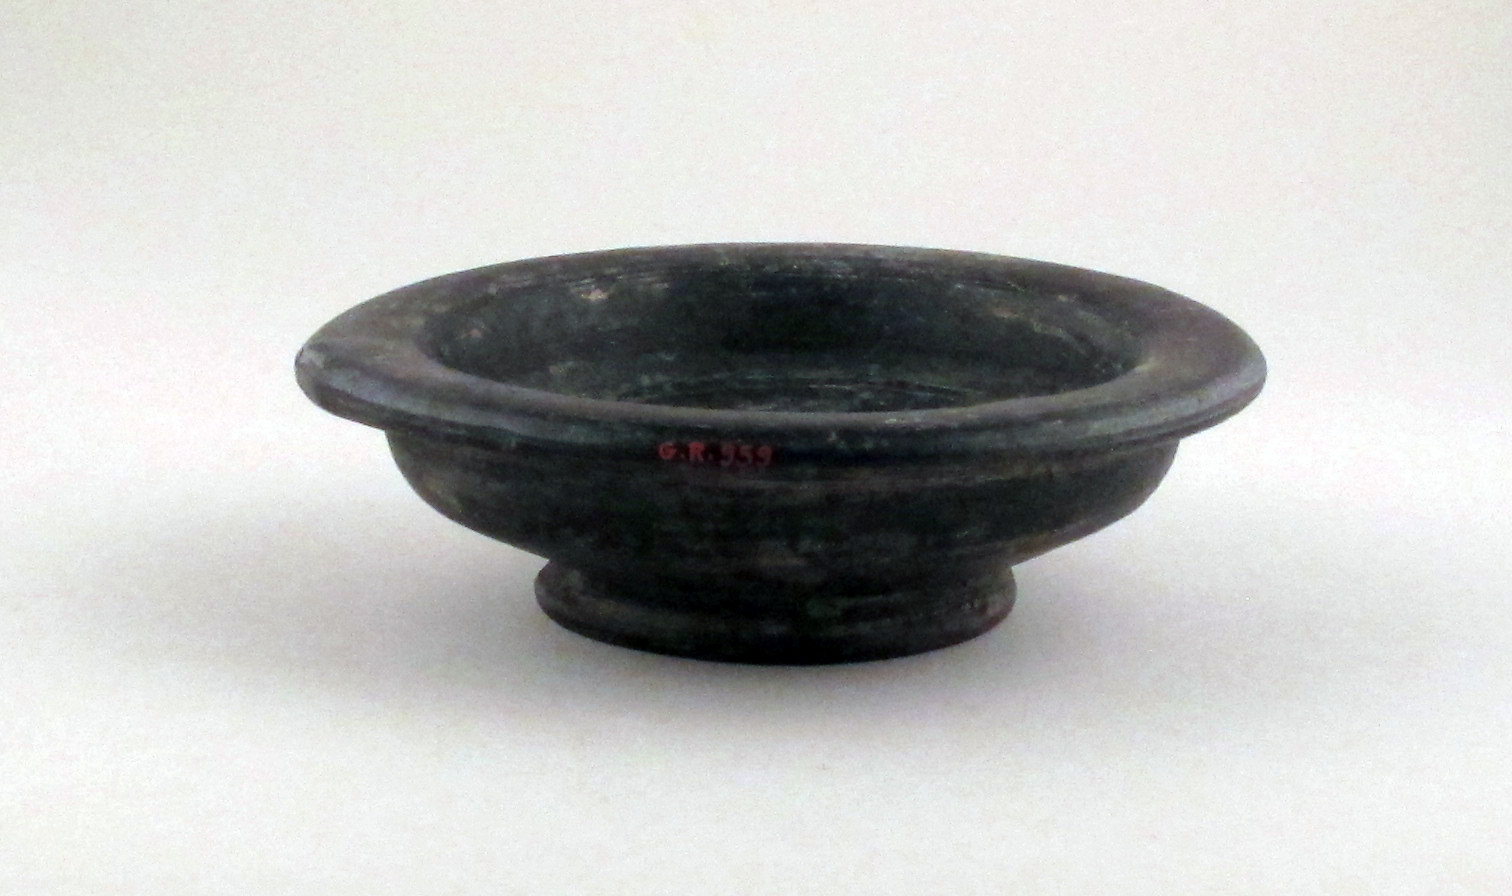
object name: dish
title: Shallow dish with foot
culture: etruscan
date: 550-500 BCE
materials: terracotta